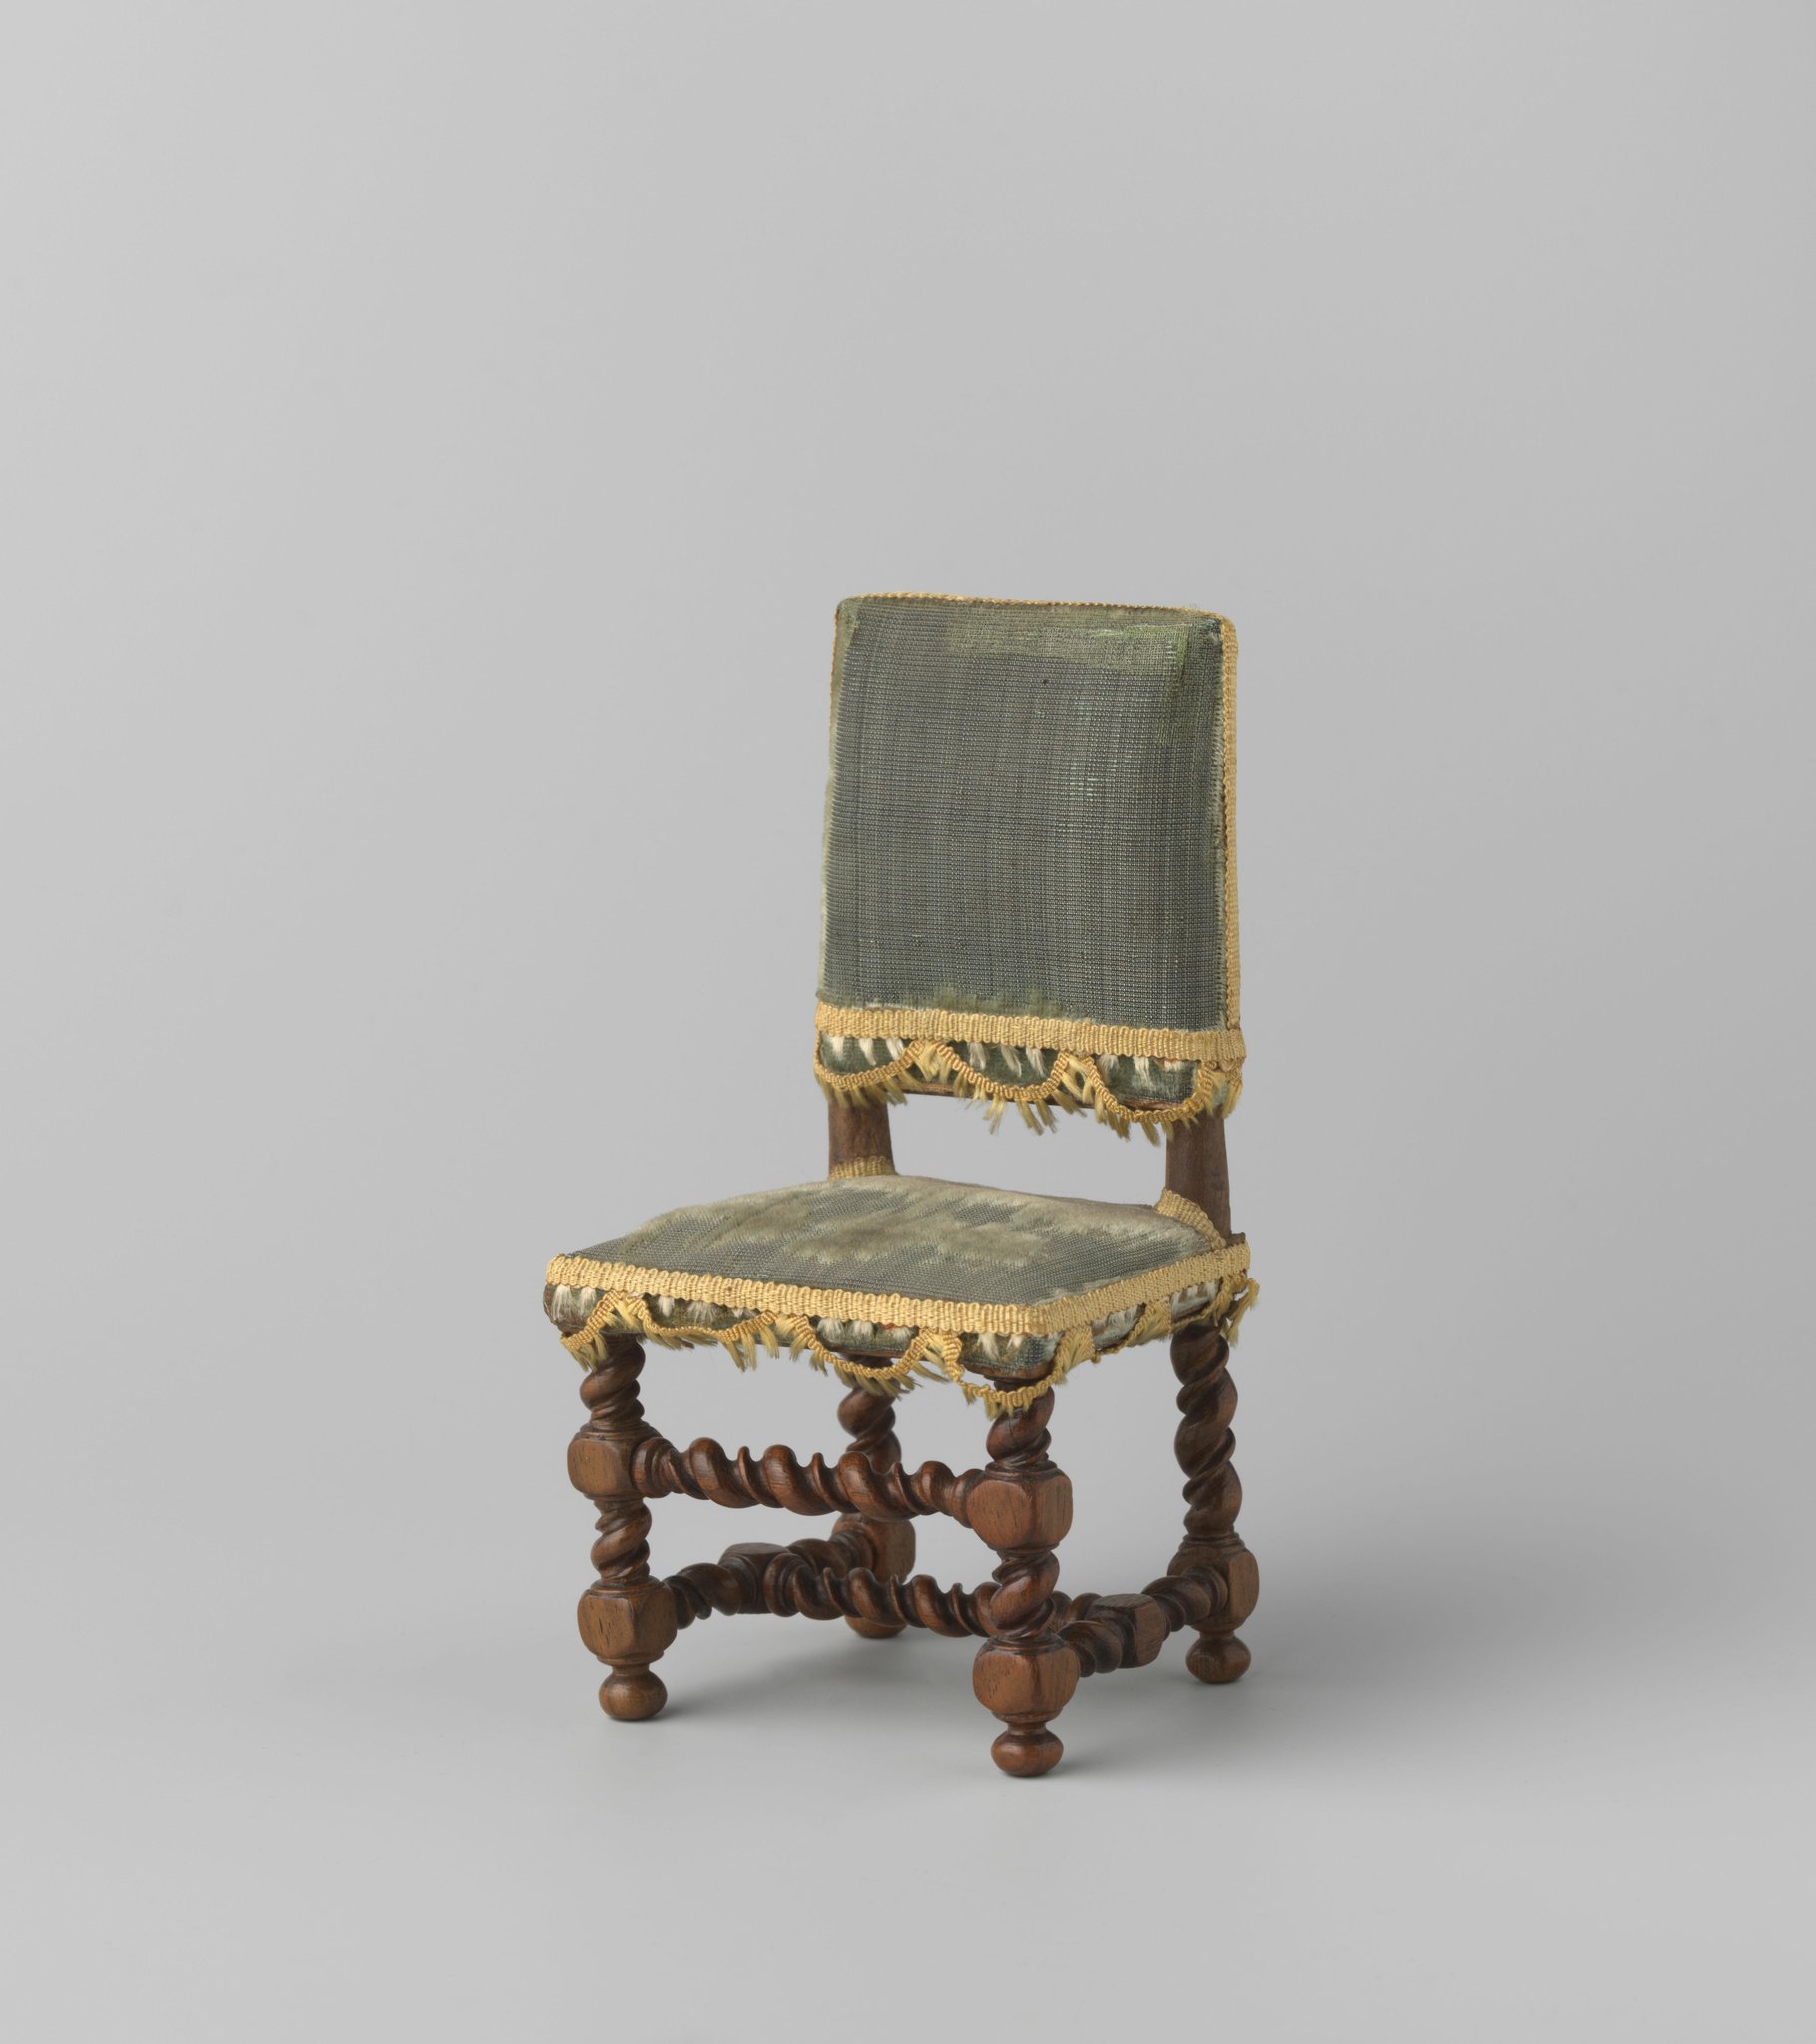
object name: leunstoel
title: Leunstoel vervaardigd van notenhout; stijlen, voorregel en H-vormig kruis met smalle en breede tors versierd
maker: Anonymous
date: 1690-1710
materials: linen, board, silk, wood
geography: amsterdam